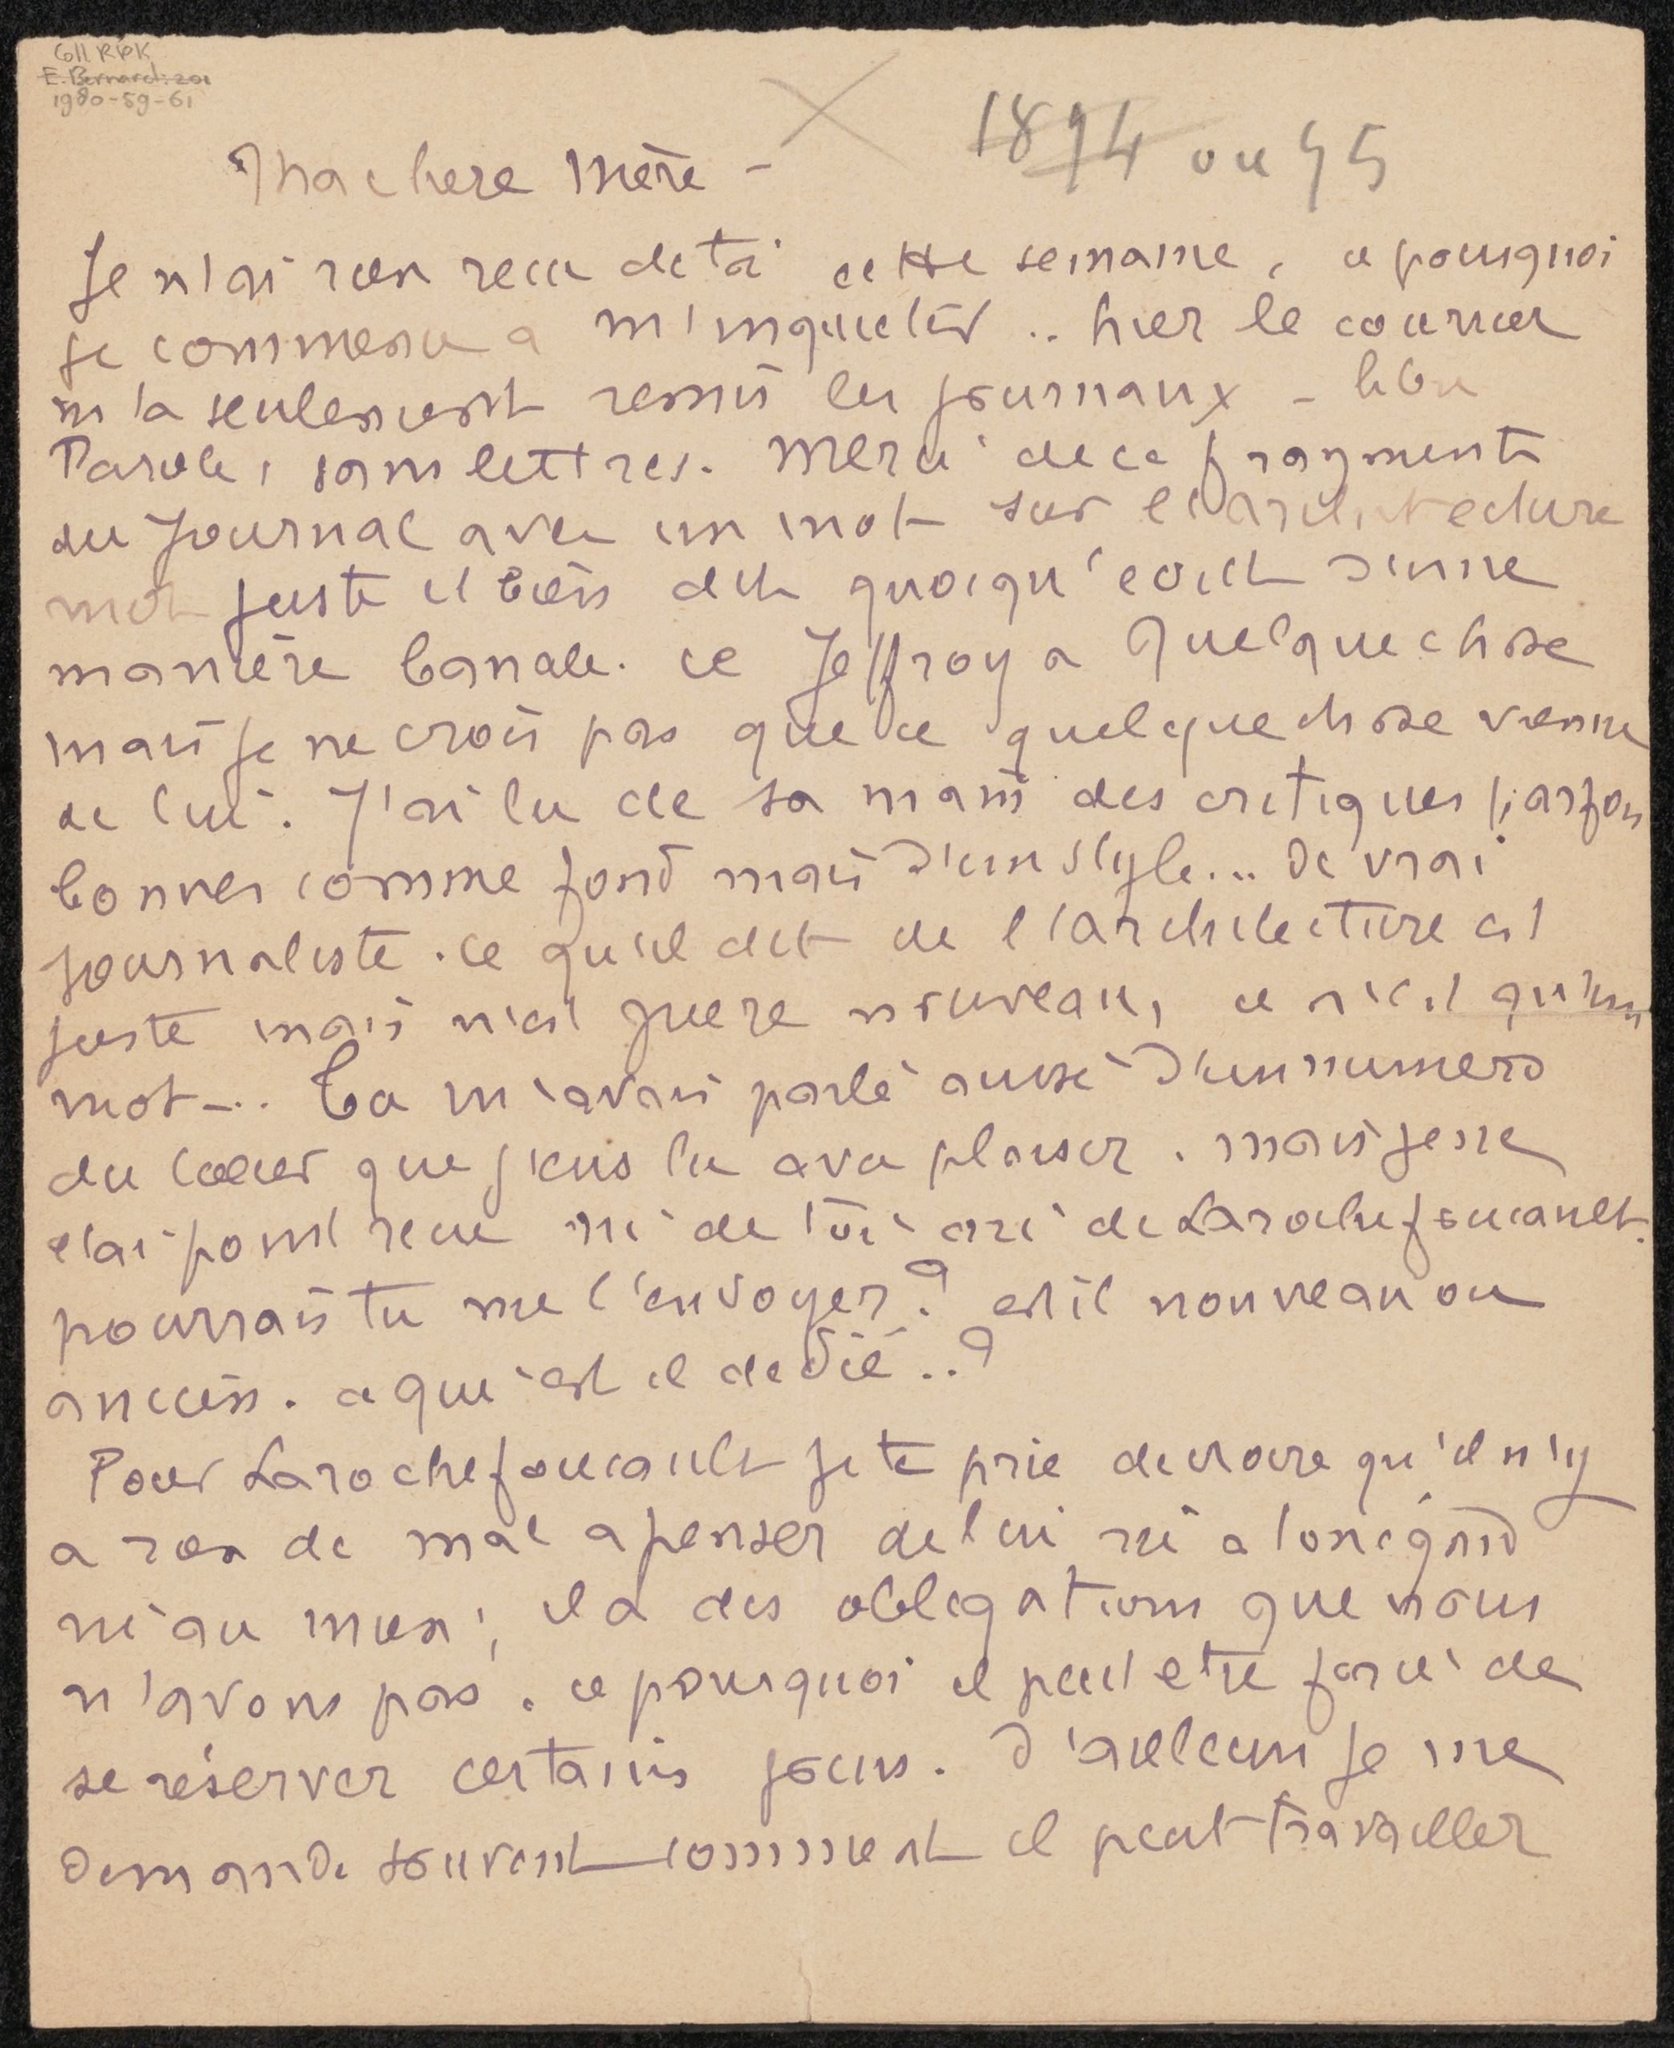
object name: letter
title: Brief aan Héloïse Bernard-Bodin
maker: émile bernard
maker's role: print maker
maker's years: 1868-1941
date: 1878-1941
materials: ink, paper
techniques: pen, writing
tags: héloïse bernard-bodin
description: Brief gedateerd 1894 [doorgehaald] ou 95 in latere hand.